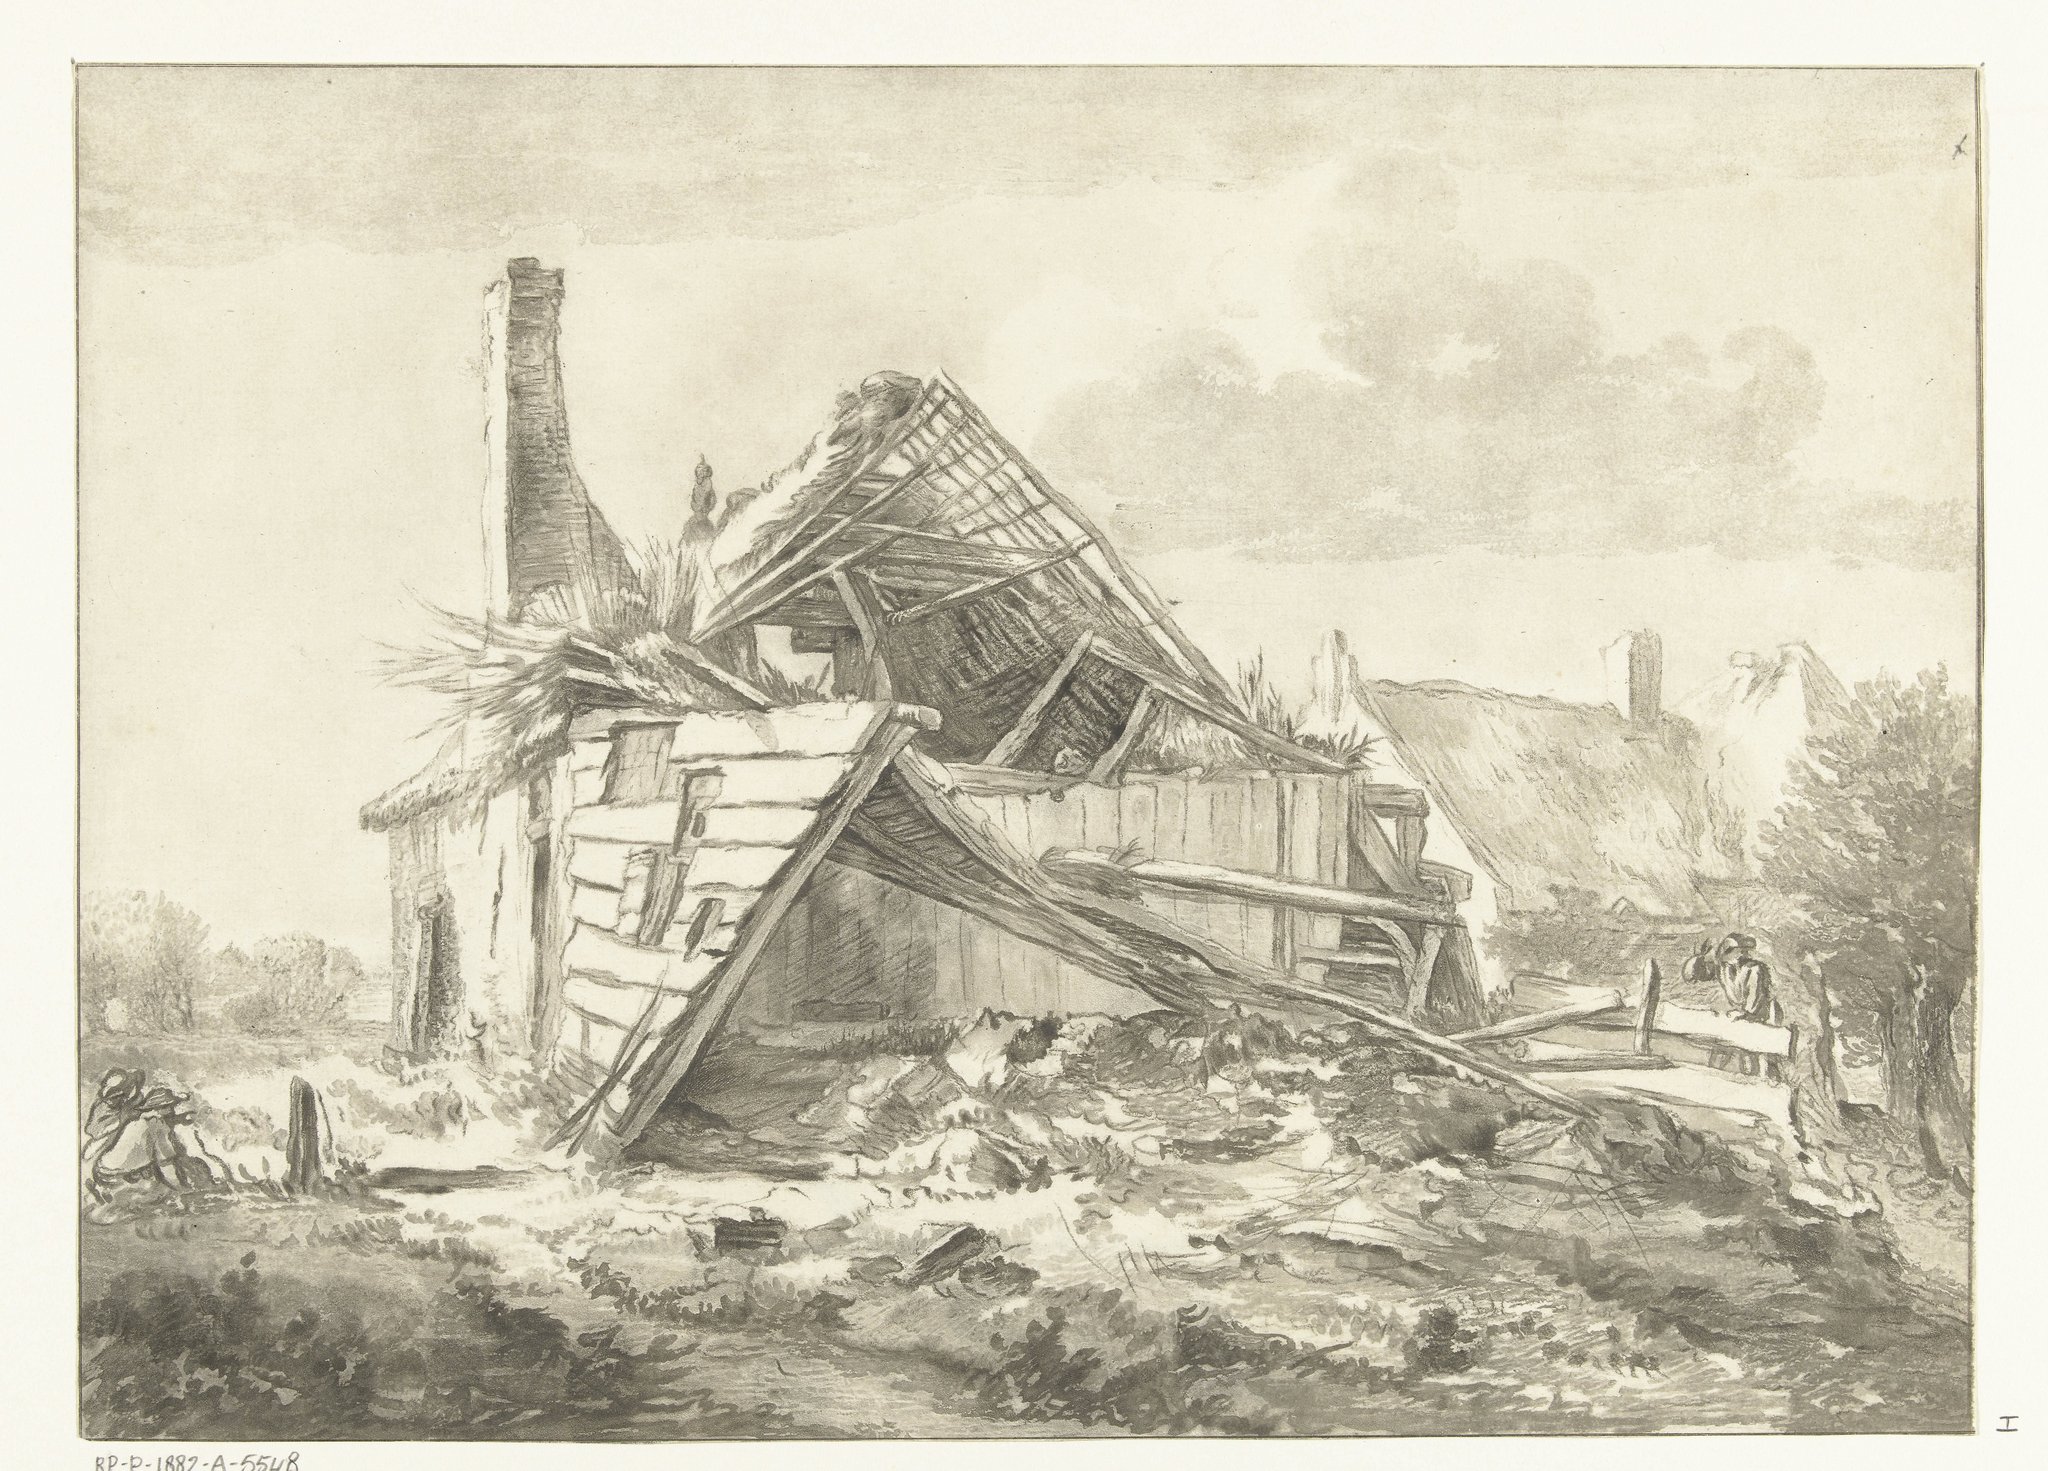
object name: print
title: Vervallen boerderij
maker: cornelis brouwer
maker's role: print maker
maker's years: 1731-1803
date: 1741-1803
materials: paper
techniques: aquatint, printmaking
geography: netherlands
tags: farm or solitary house in landscape, neglected dwelling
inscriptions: collector's mark: Lugt 2228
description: Prent naar tekening van Jacob Isaacksz. van Ruisdael. Prent uit serie van negen prenttekeningen met acht landschappen en een zeegezicht naar Hollandse meesters uit de 17e eeuw, zie Huffel 1921, p. 33-35.